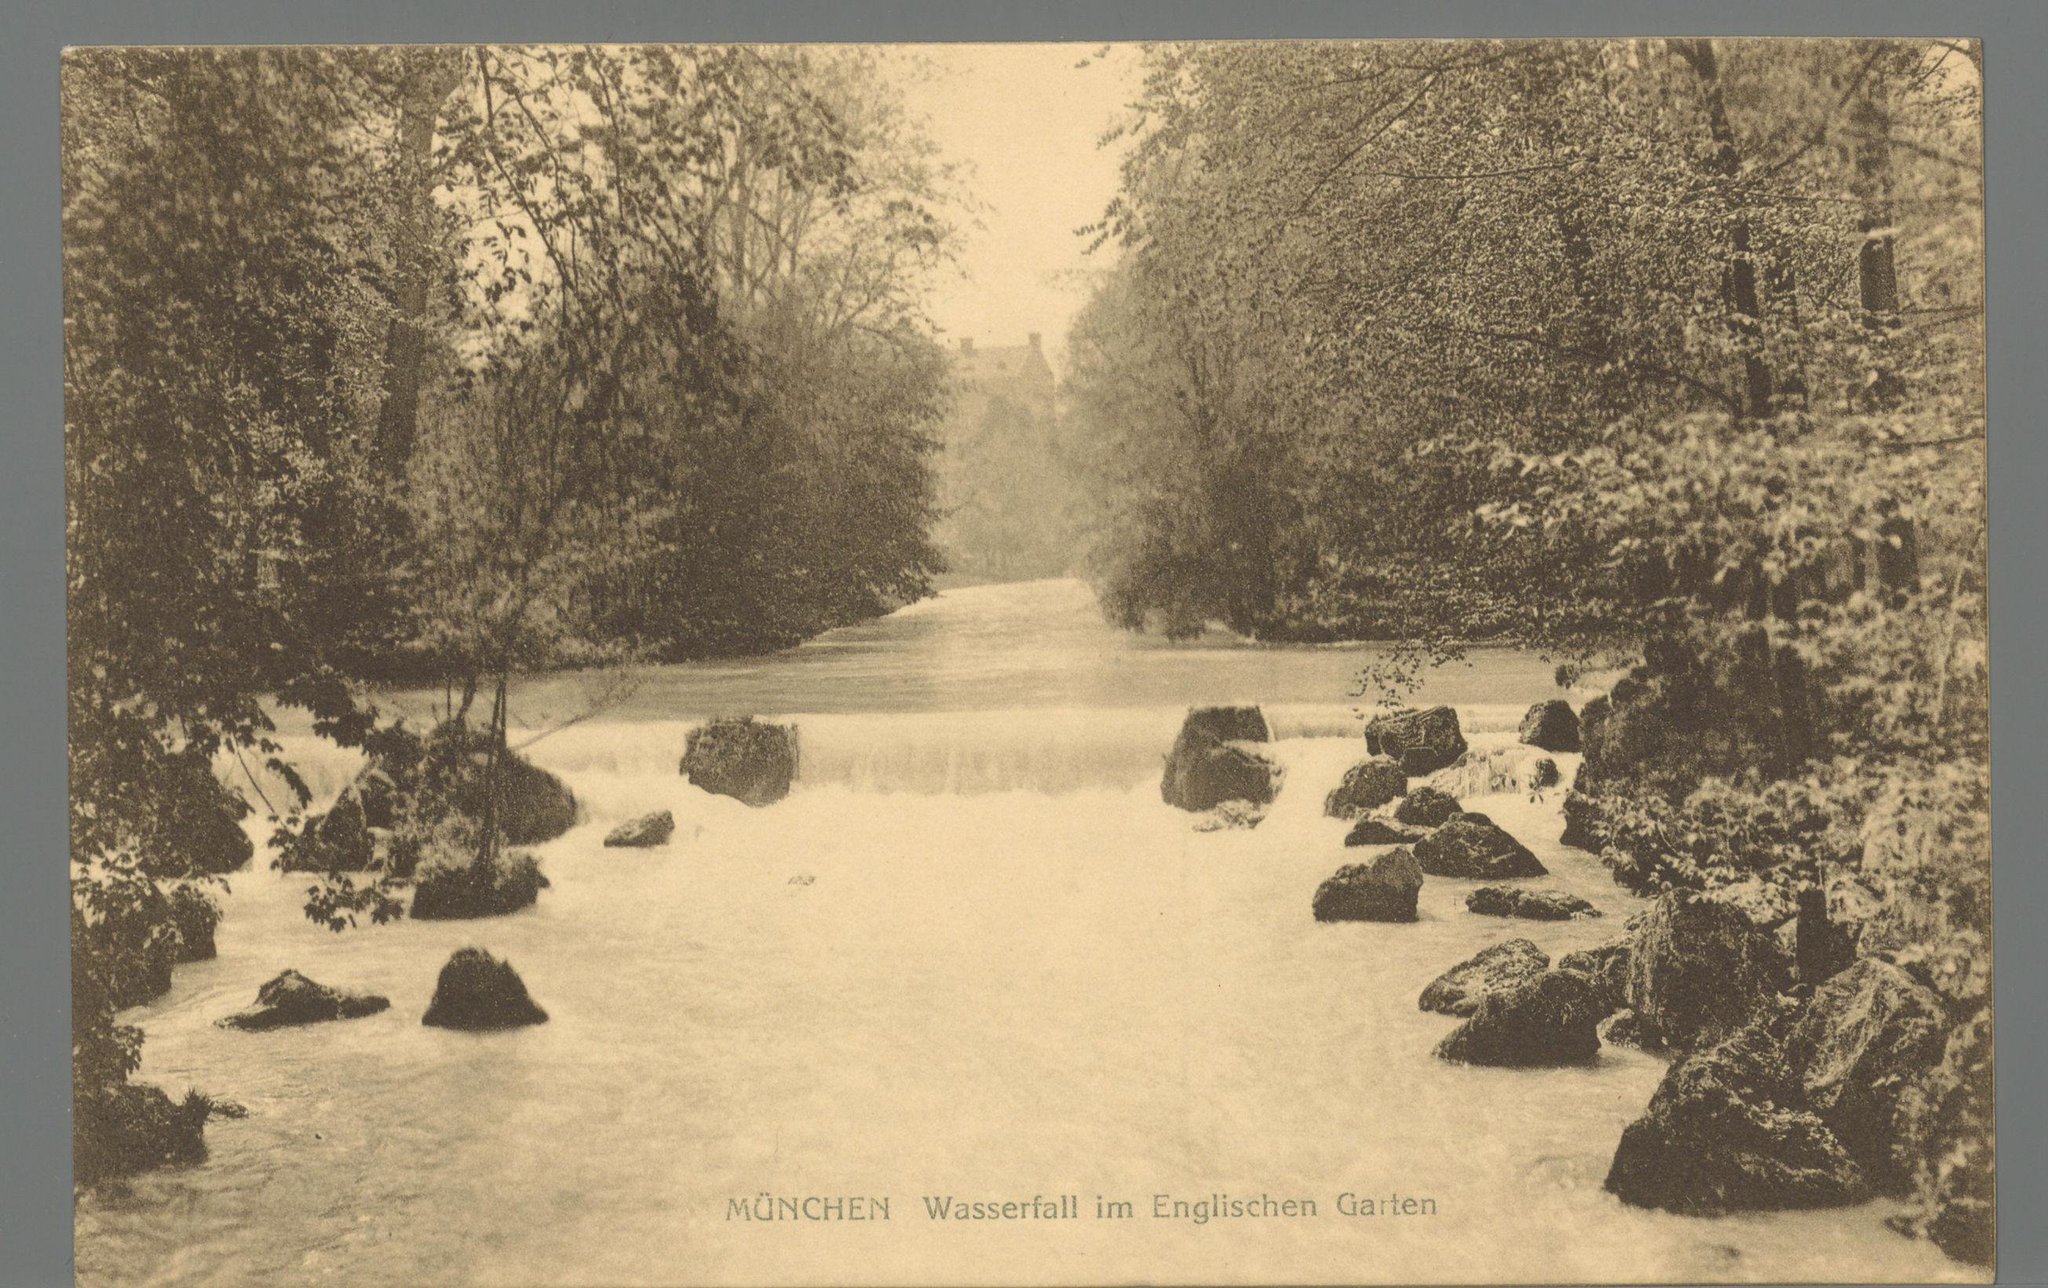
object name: ansichtkaart, prentbriefkaart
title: München. Wasserfall im Englischen Garten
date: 1905-1930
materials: cardboard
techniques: photograph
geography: munich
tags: park, waterfall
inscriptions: inscription: ‘W.H.D.’